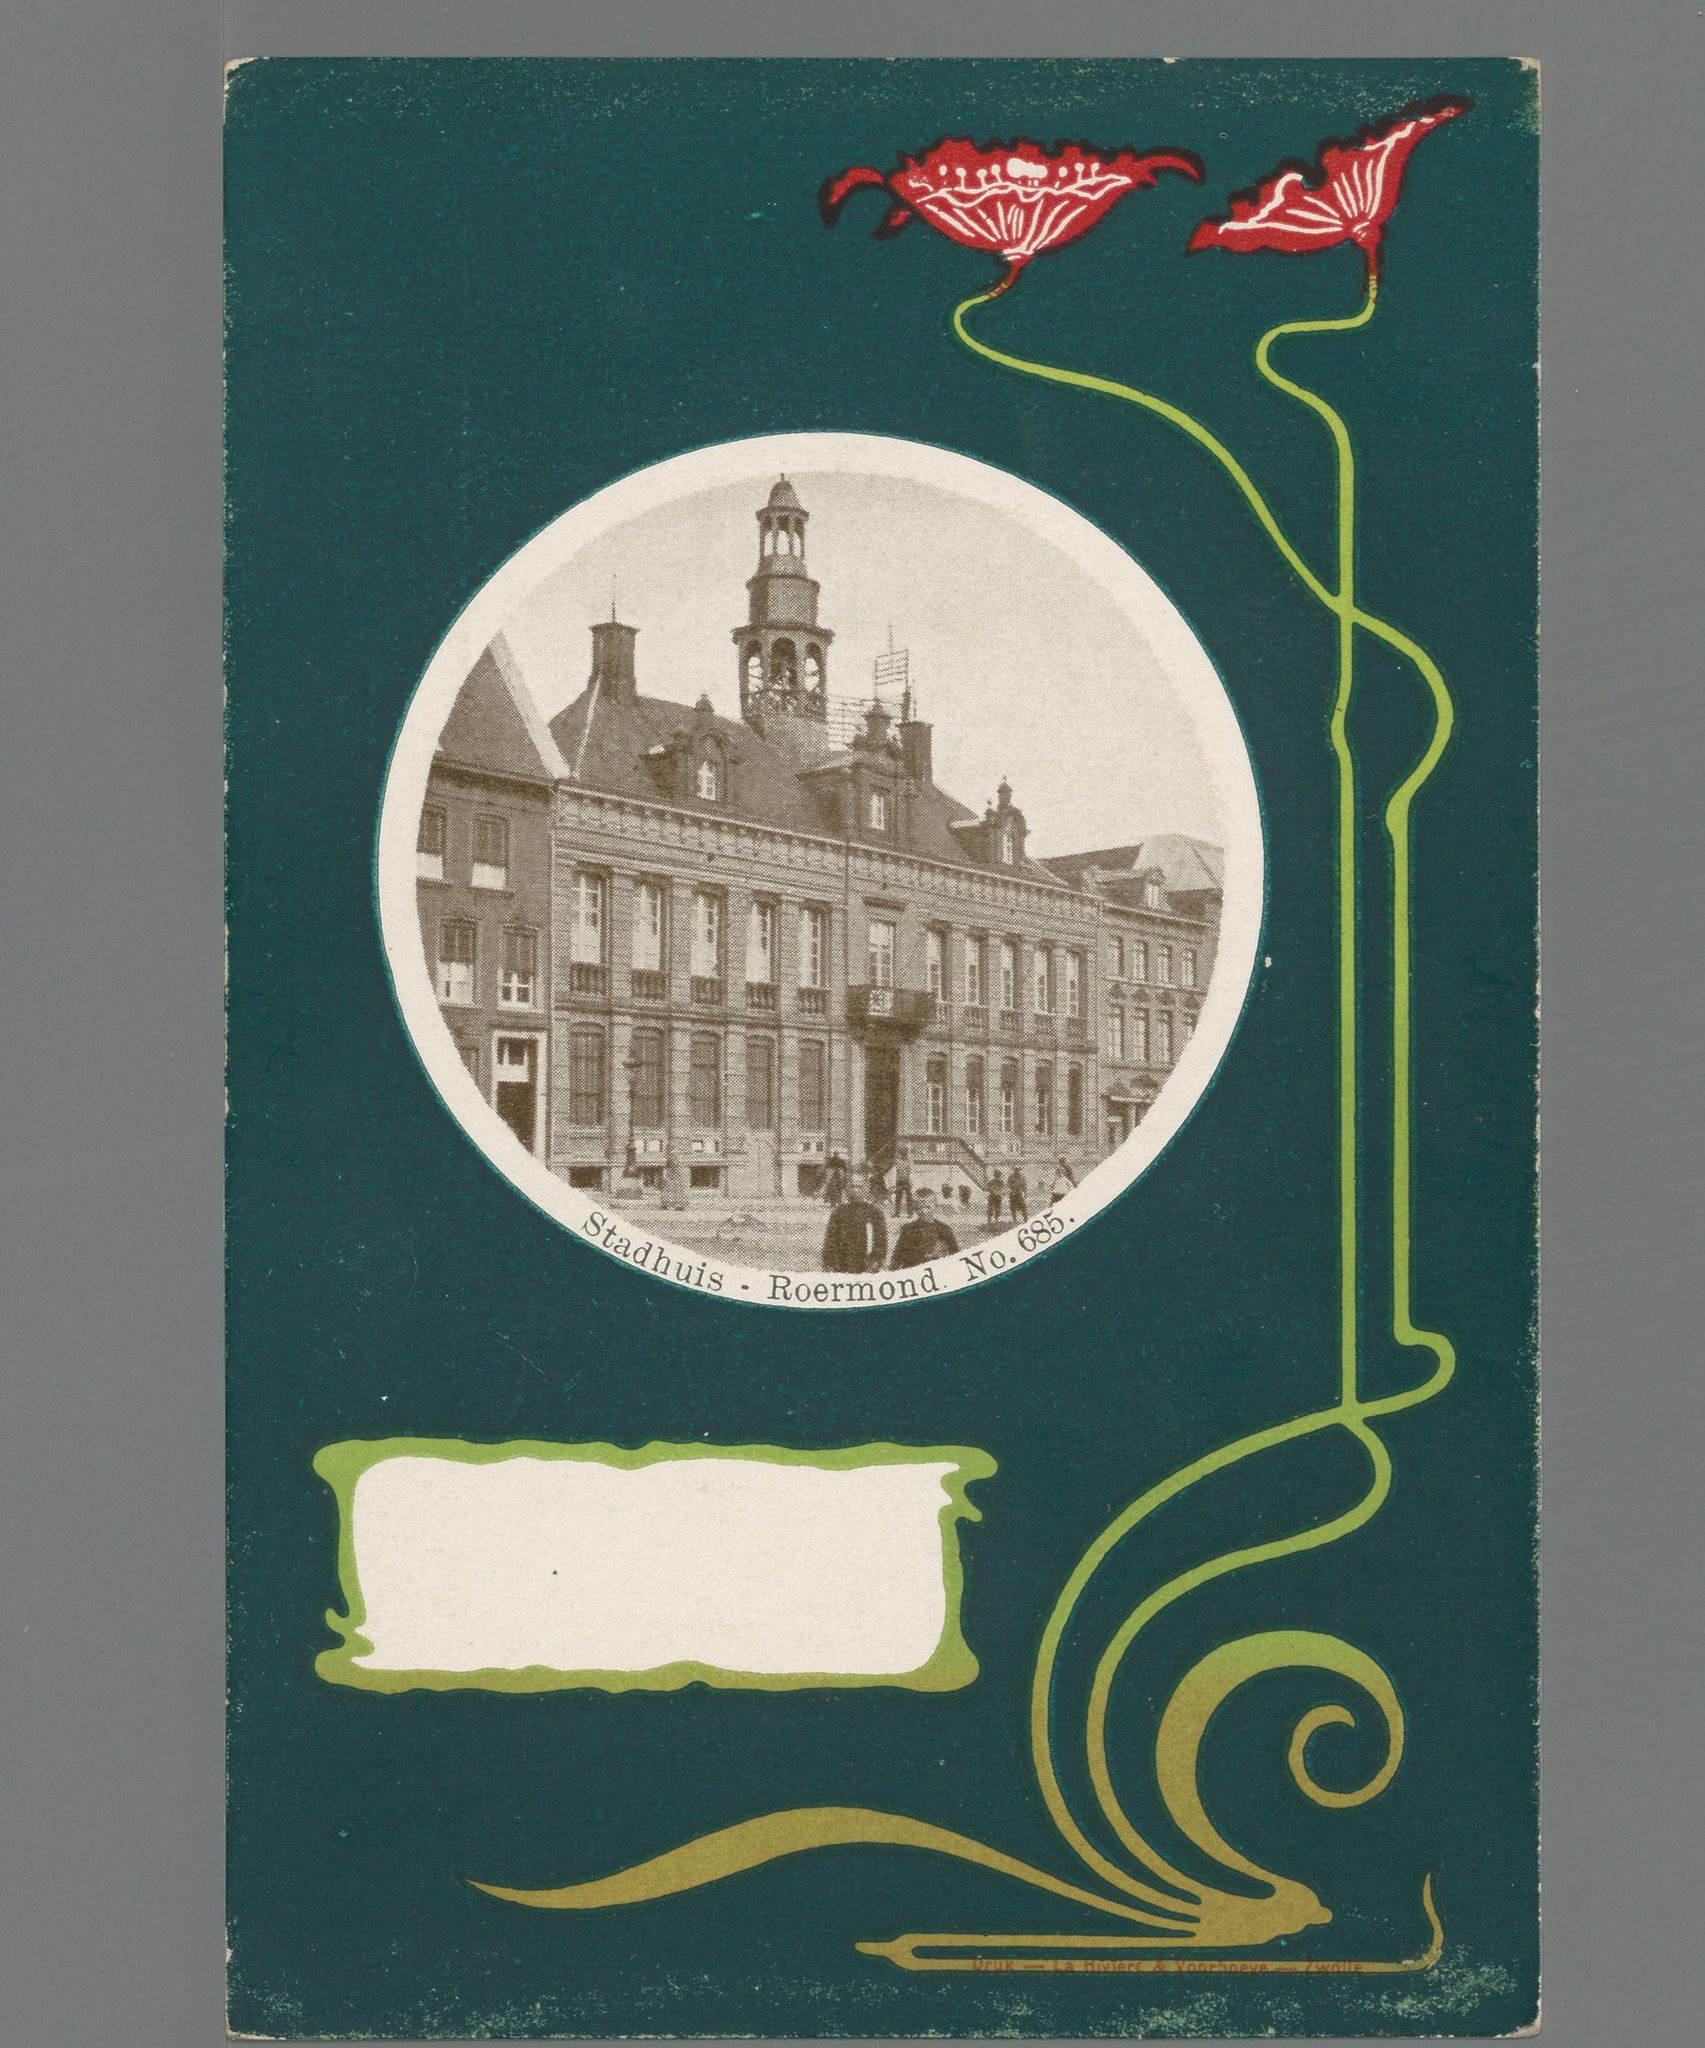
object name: photomechanical print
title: Stadhuis - Roermond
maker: Anonymous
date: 1900-1904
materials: cardboard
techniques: printing block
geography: roermond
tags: townhall